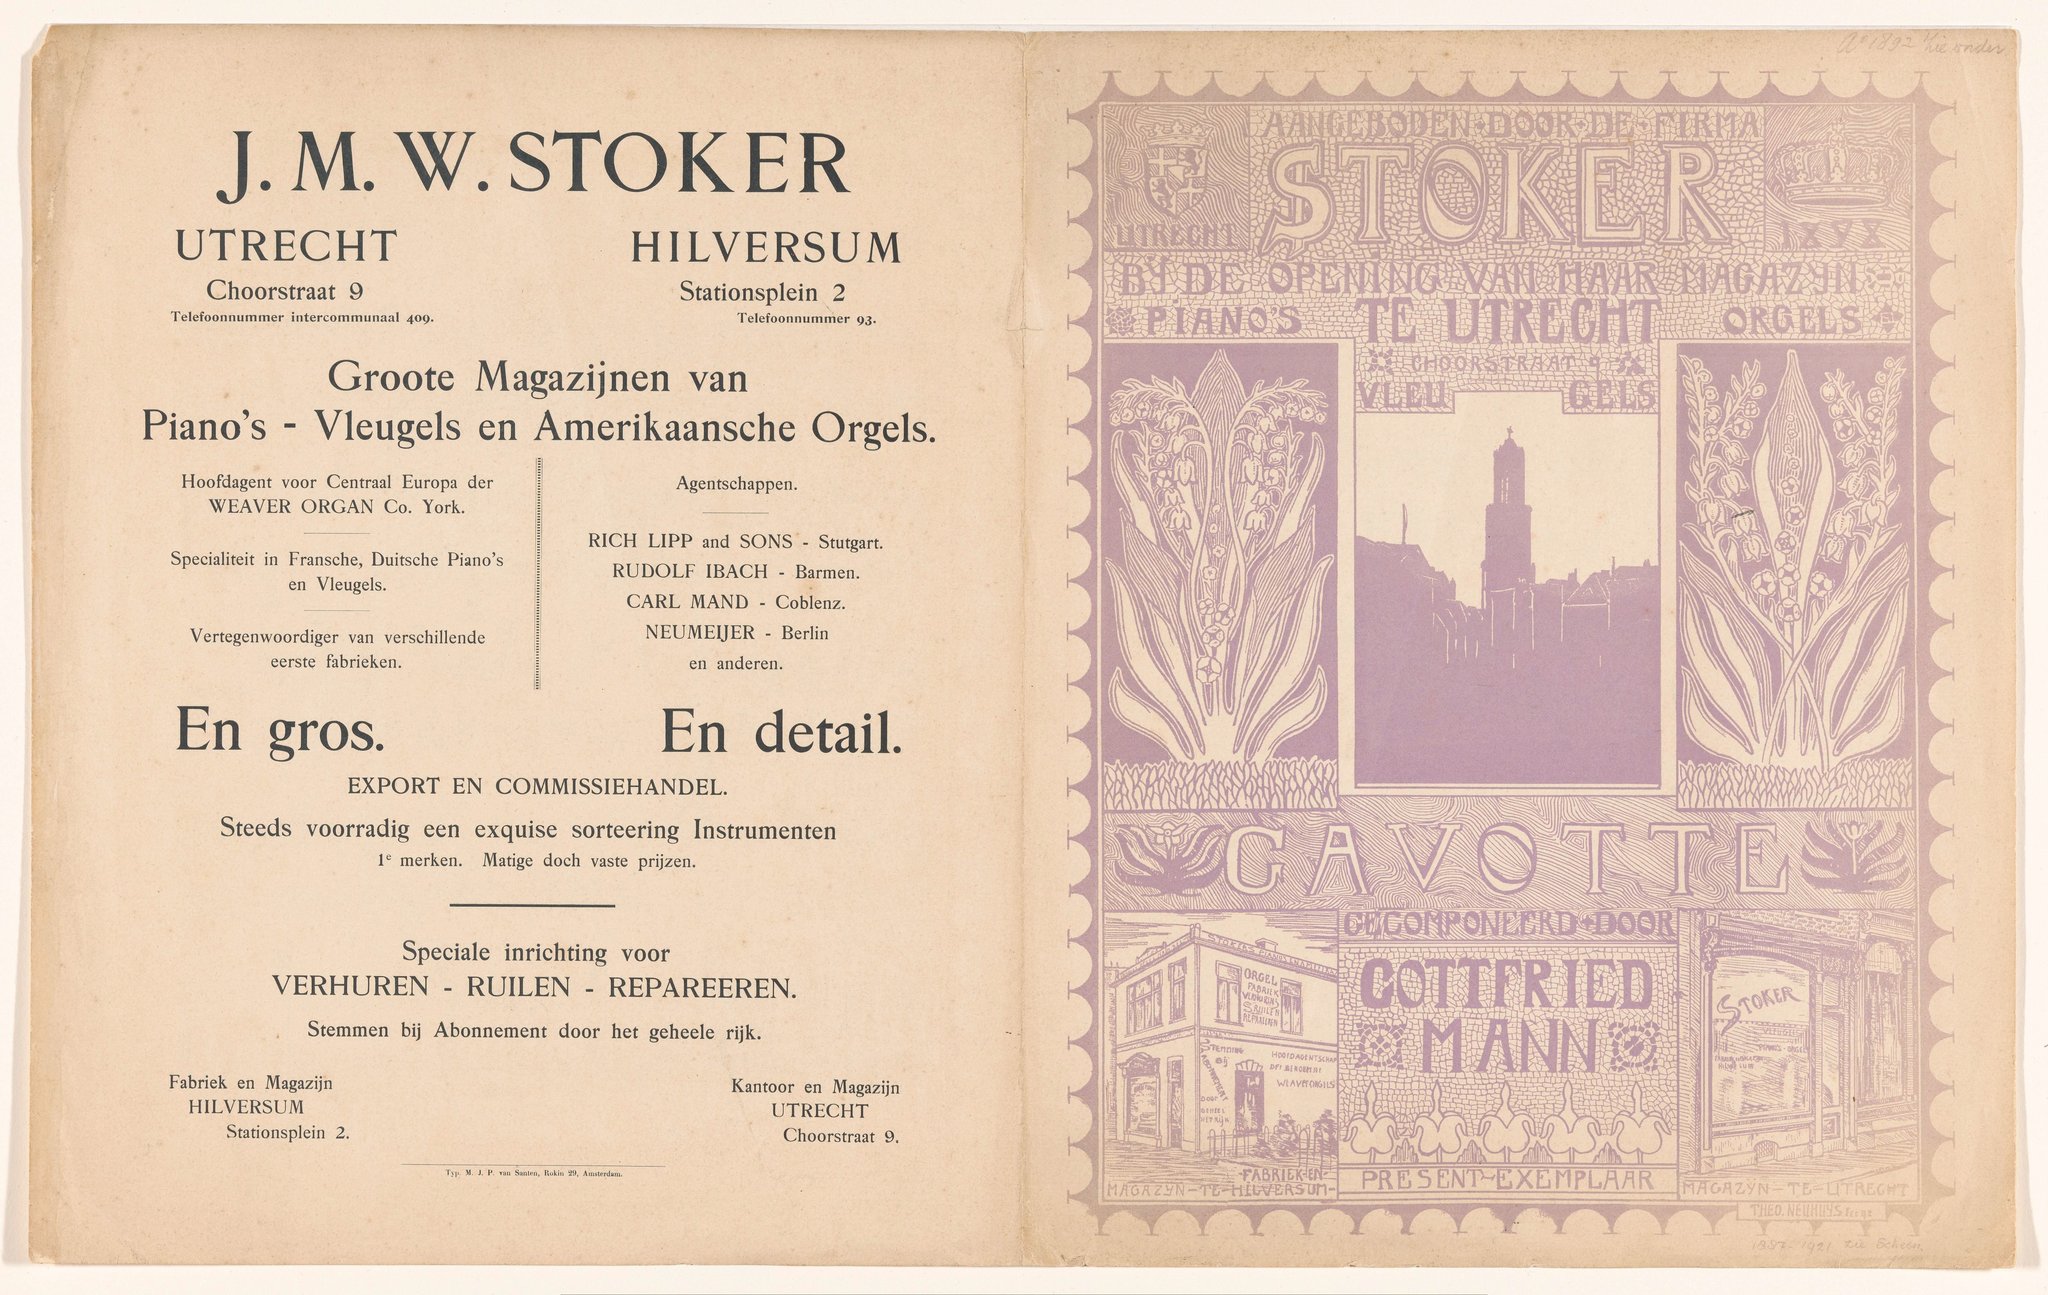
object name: brochure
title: Brochure van pianohandel Stoker met de Domtoren van Utrecht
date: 1898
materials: paper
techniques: letterpress printing, lithograph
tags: shop, store, flowers, keyboard instruments, parts of church exterior and annexes: tower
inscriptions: collector's mark: Lugt 2228, collector's mark: Lugt 2760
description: Links een advertentie. Rechts het titelblad met bovenaan de tekst: 'Aangeboden door de firma Stoker bij de opening van haar magazijn te Utrecht'. In het midden de Domtoren van Utrecht geflankeerd door twee kaders met bloemen. Linksonder de fabriek van de firma Stoker in Hilversum en rechtsonder de gevel van het magazijn in Utrecht. Op verso het muziekstuk Gavotte.